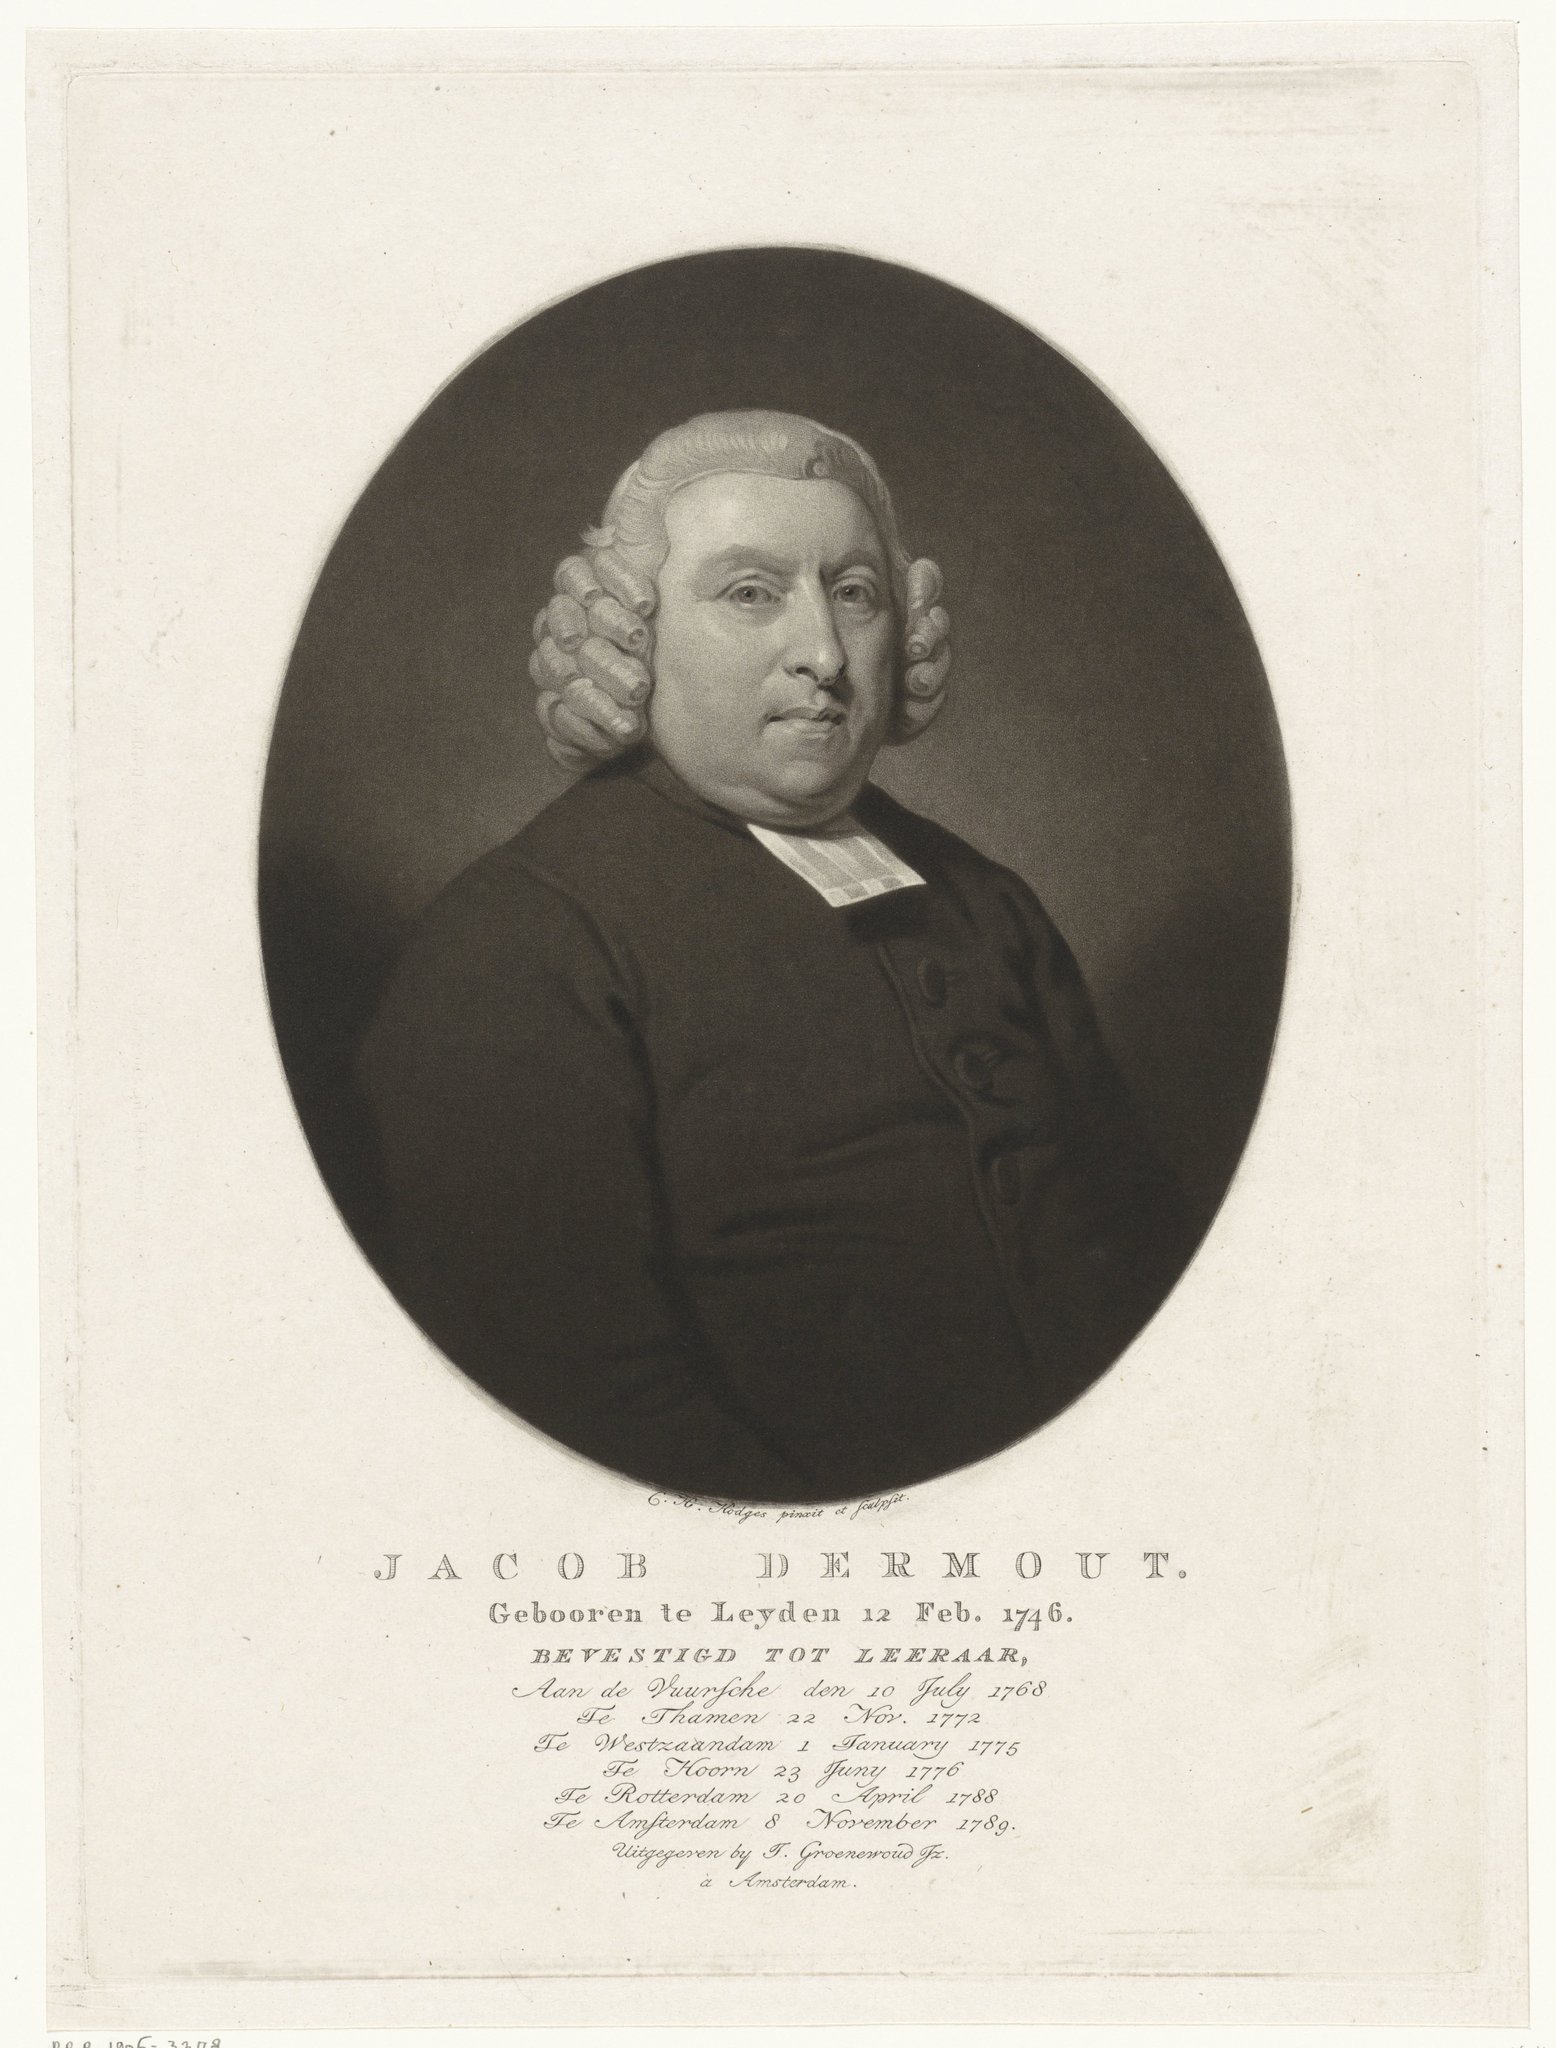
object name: print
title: Portret van de predikant Jacob Dermout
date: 1807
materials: paper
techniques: engraving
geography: amsterdam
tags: wig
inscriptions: collector's mark: Lugt 2228